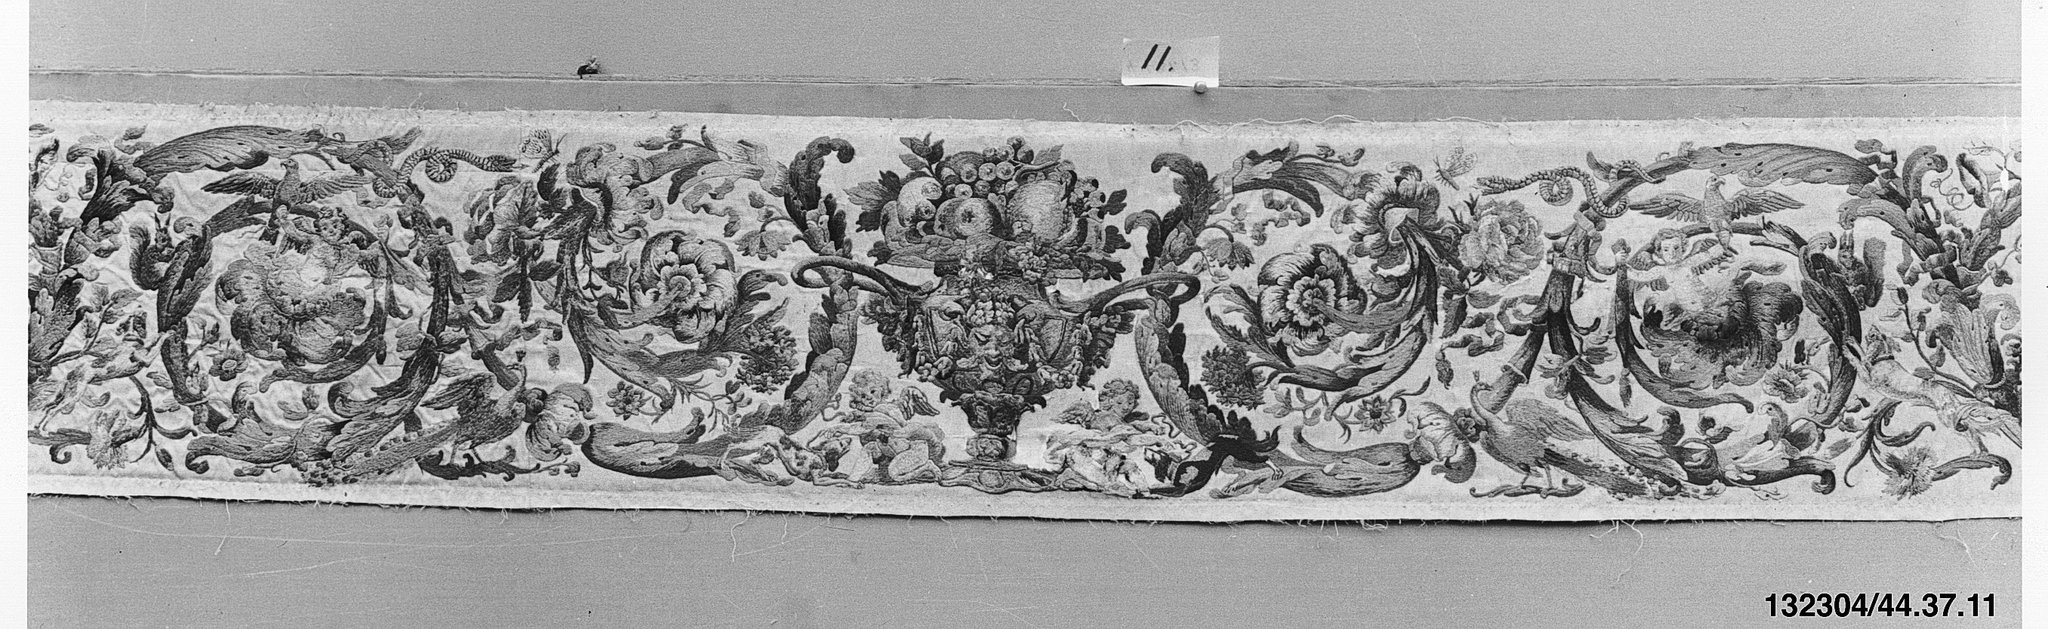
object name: valance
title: Valance (one of a set of six)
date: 1667-1733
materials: silk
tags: flowers